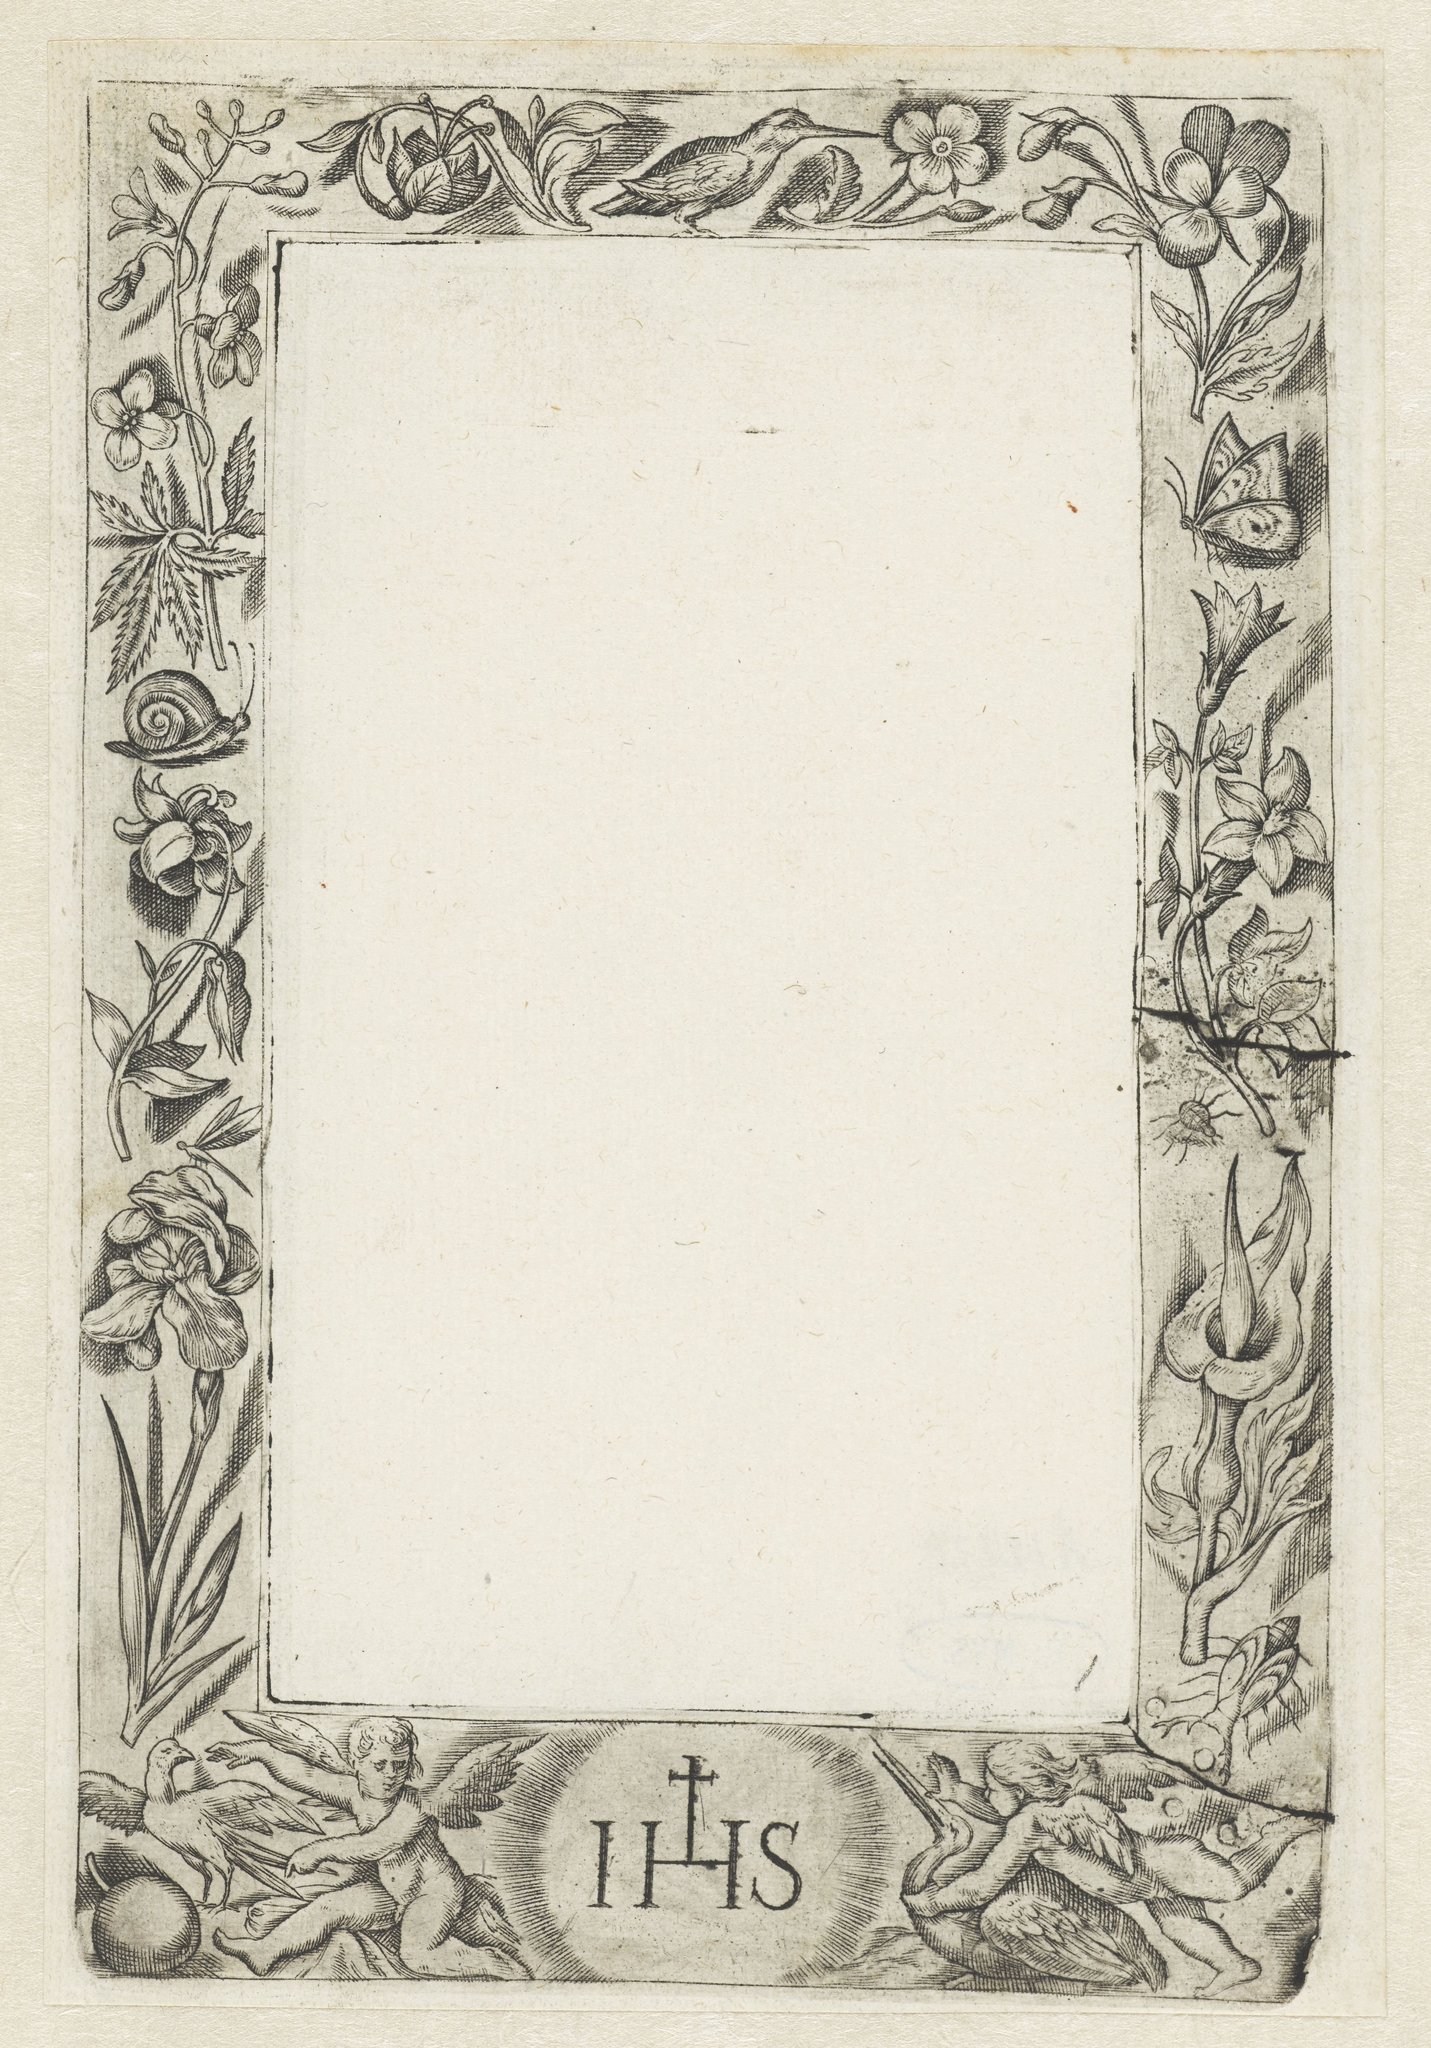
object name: ornament print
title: Omlijsting met onderaan het Christusmonogram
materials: paper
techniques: etching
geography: netherlands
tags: ihs ('iesus hominum salvator') ~ symbol of christ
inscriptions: inscription: ‘1’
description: In de opstaande randen is links een iris en rechts een aronskelk afgebeeld. Eén van 6 bladen, aan weerszijden bedrukt, met acht verschillende omlijstingen rondom een niet bedrukt middenveld.